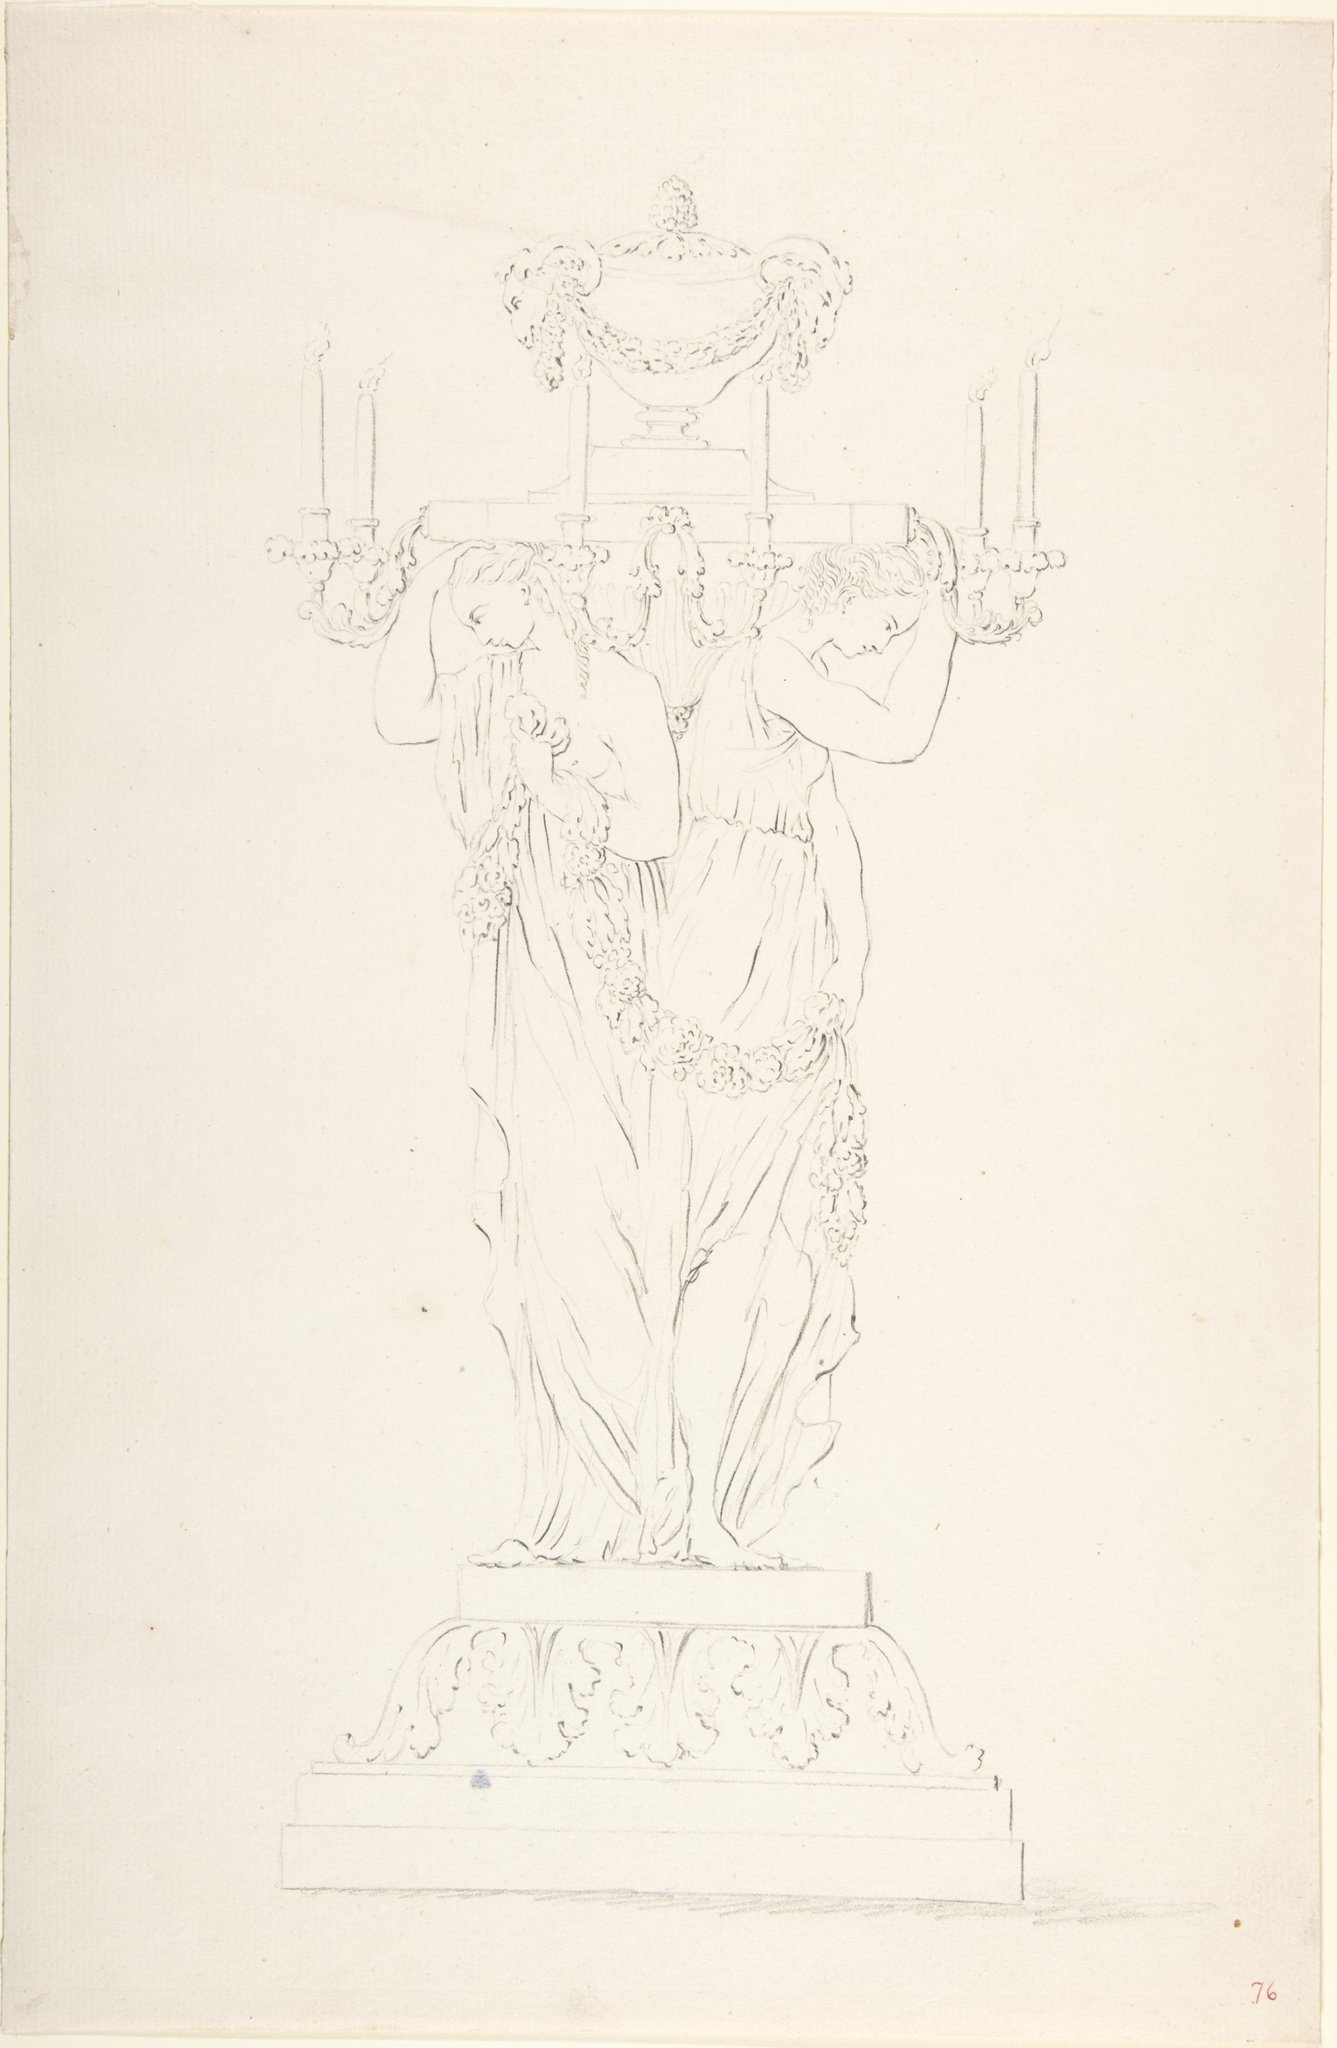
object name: drawing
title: Design for a Candelabra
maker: anonymous, french, 18th century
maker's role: artist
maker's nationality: french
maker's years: 1700-1800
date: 1770-1790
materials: graphite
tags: candelabra